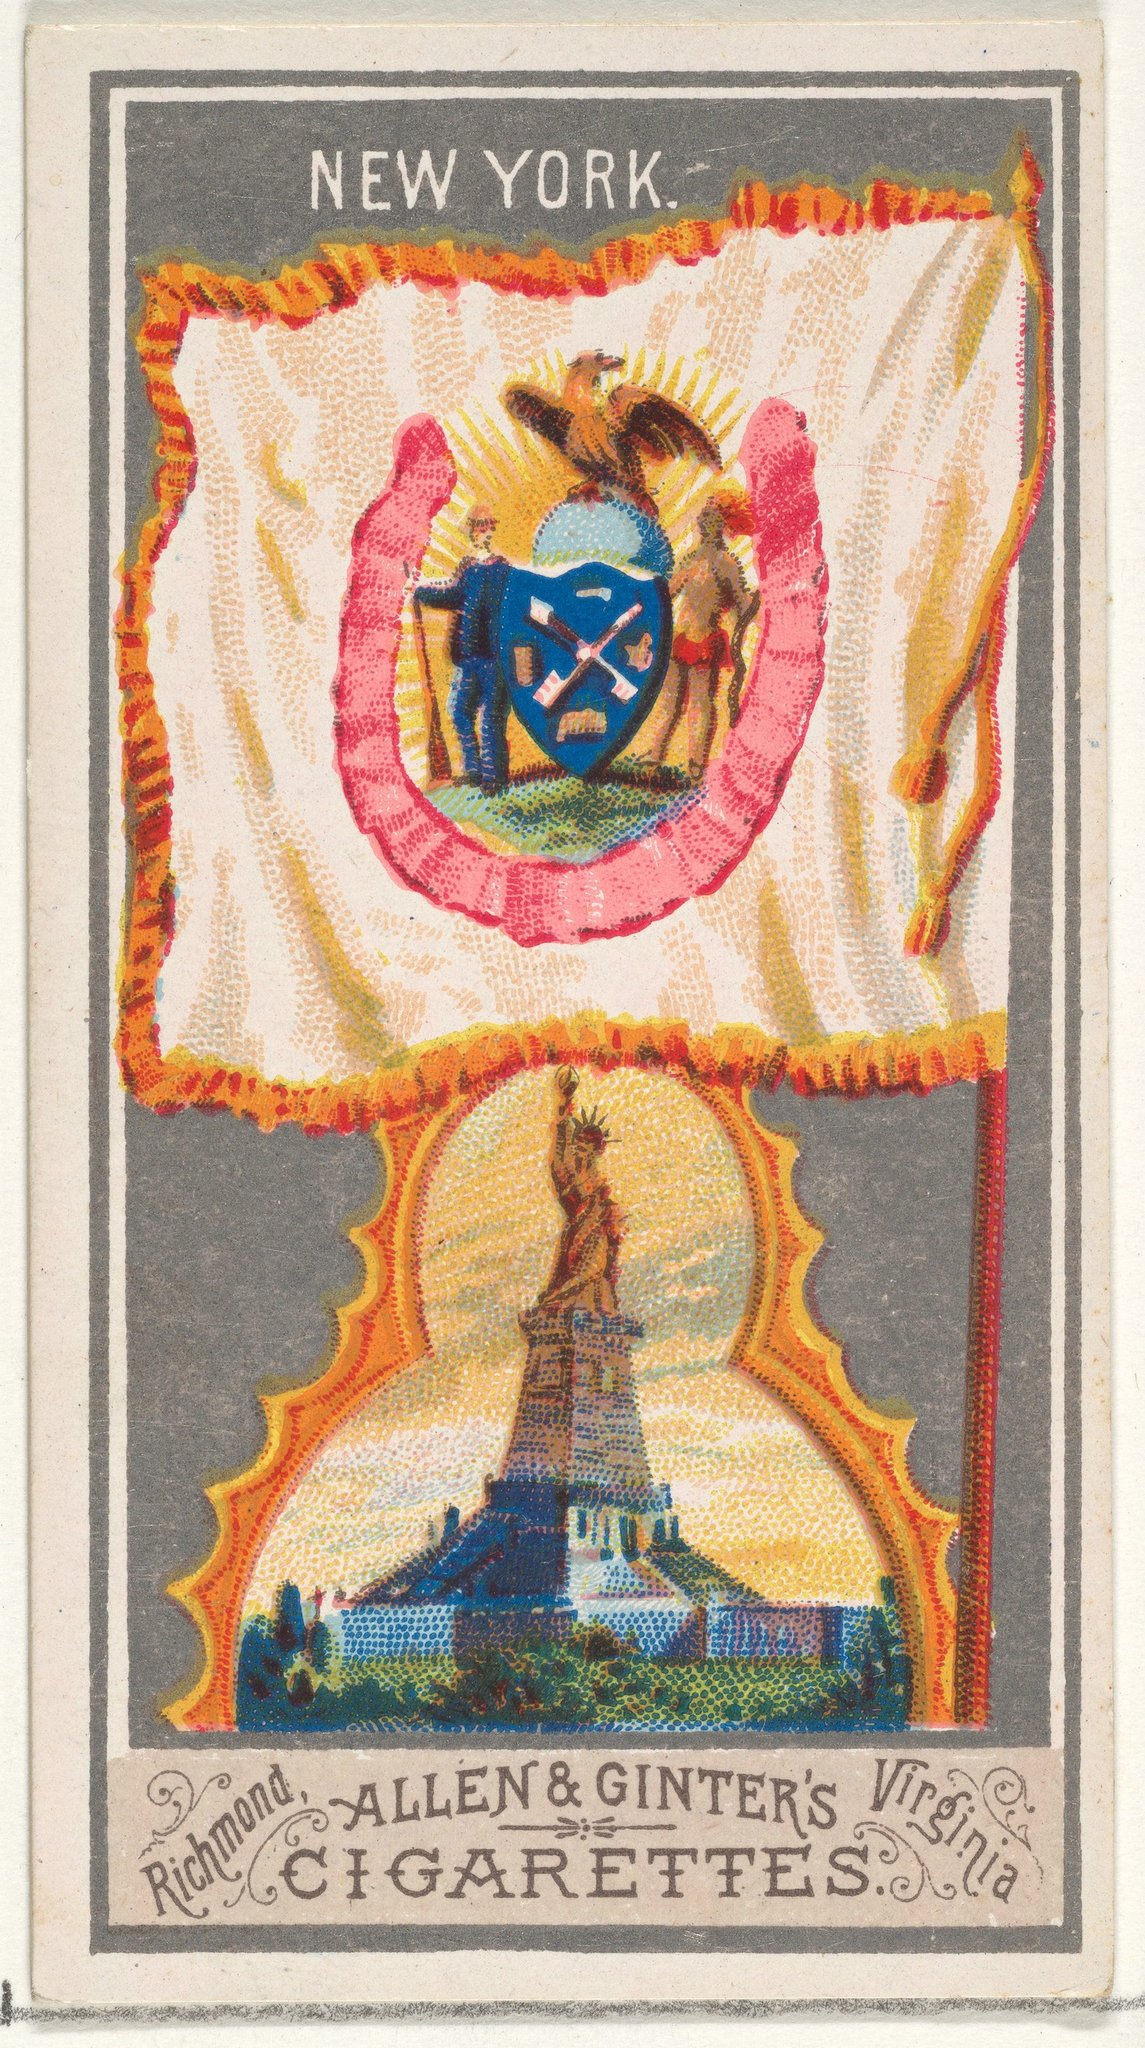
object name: print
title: New York, from the City Flags series (N6) for Allen & Ginter Cigarettes Brands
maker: allen & ginter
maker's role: publisher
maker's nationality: american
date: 1887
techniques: color lithograph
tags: eagles,coat of arms,flags